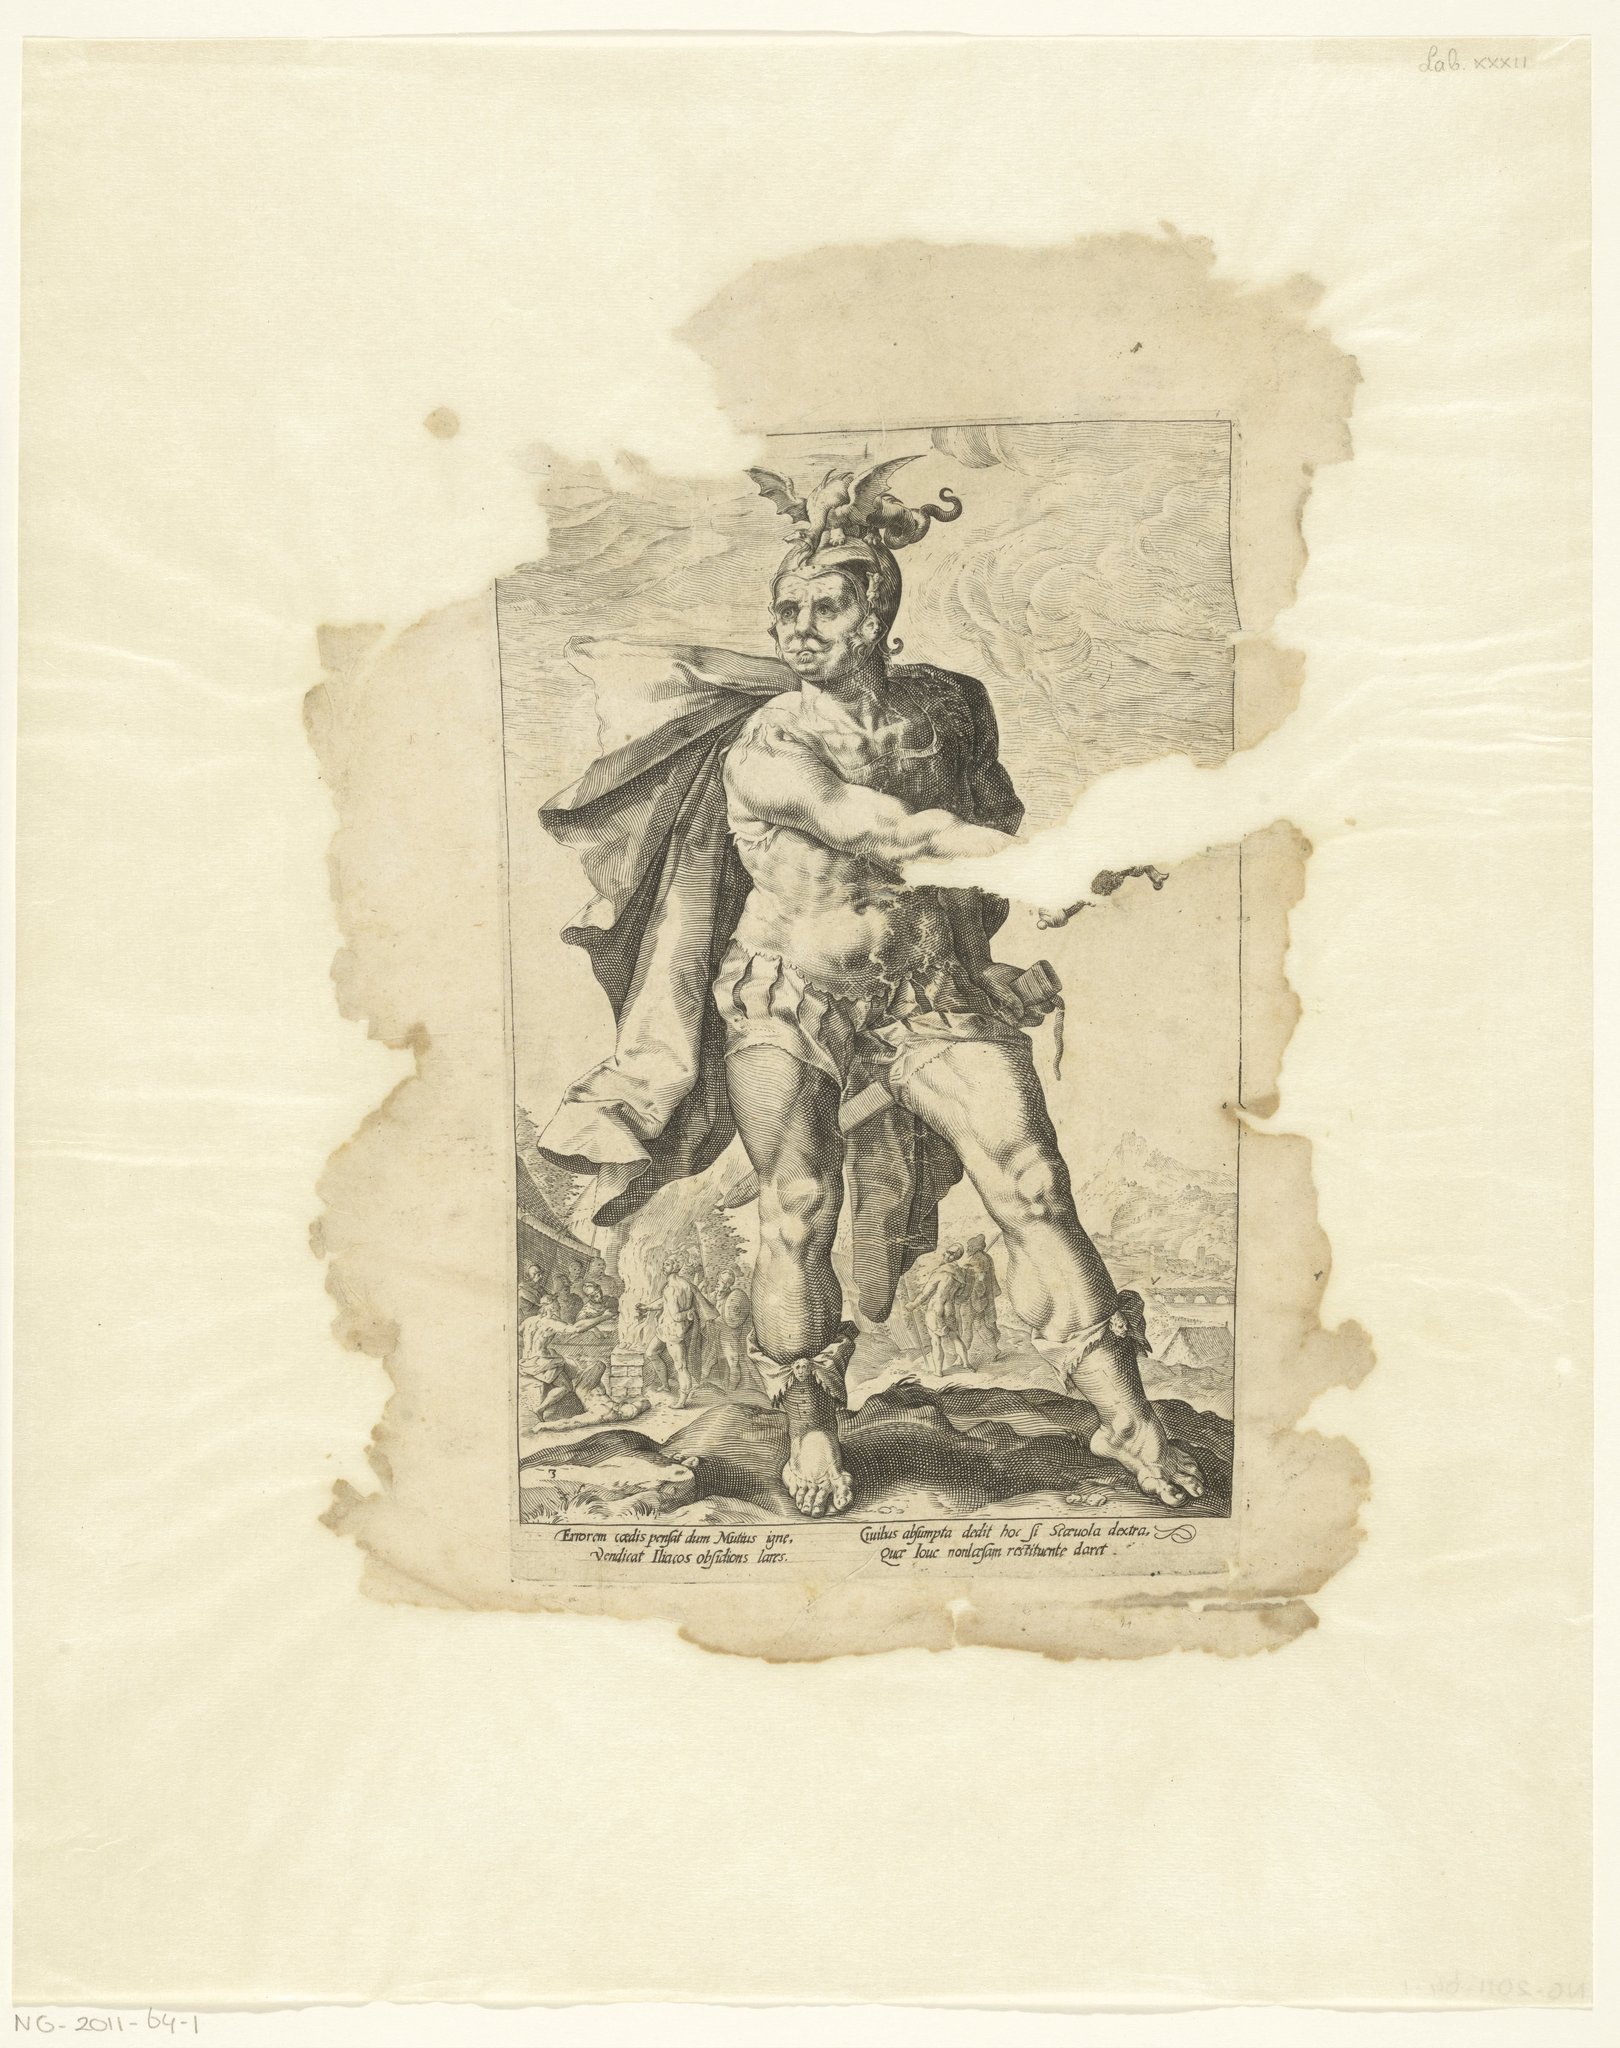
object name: print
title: Romeinse helden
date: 1586-1596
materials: paper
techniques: engraving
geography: northern netherlands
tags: gaius mucius scaevola before porsena: he thrusts his right hand into the flames (the body of the king's secretary who erroneously had been killed instead of porsena may be seen lying on the ground)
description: Deze prent is onderdeel van een serie van tien prenten, bestaand uit een ongenummerde titelprent, acht genummerde voorstellingen van helden en een ongenummerde afsluitende prent. De prenten in de Nova Zembla collectie zijn tijdens een expeditie van Willem Barendsz en Jacob van Heemskerk in 1596-1597 noodgedwongen in het winterkamp, het ‘Behouden Huis’, op het eiland achtergelaten. De prenten waren in één of meerdere stapels als handelswaar meegenomen vanuit Amsterdam. Bijna drie eeuwen later, in 1871, keerde de Noor Elling Carlsen terug naar Nova Zembla en vond daar de restanten van het ‘Behouden Huis, inclusief een groot deel van de inventaris. Een deel van de prenten, in de vorm van aaneengekoekte kluiten, werd toen ook teruggevonden. De papierkluiten waren soms op meerdere plekken gebroken. Tussen 1975-1979 zijn de prenten van elkaar gescheiden. Dit leverde in totaal ca. 1000 fragmenten van ca. 400 afdrukken van ca. 150 verschillende prenten op. Voor zover mogelijk zijn de fragmenten samengevoegd en zijn de prenten gereconstrueerd.